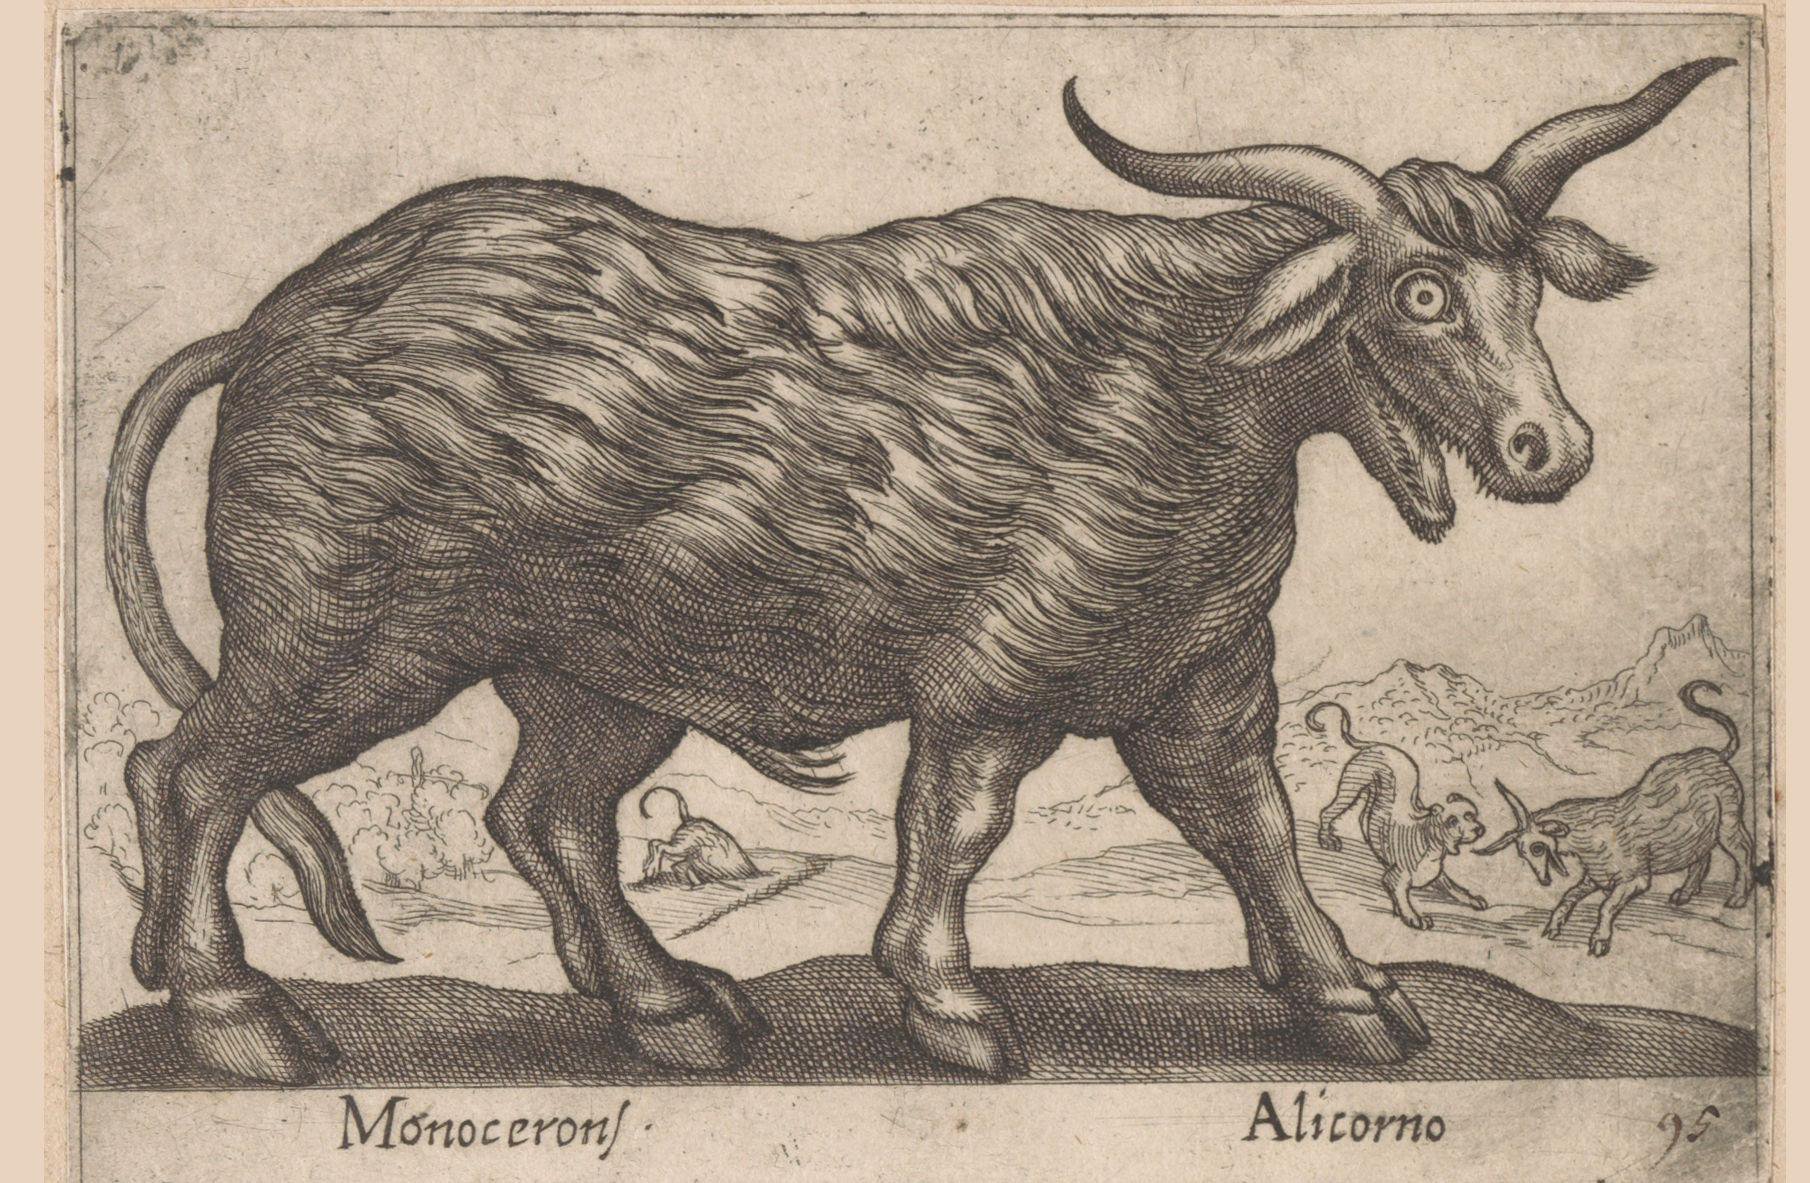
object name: print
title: Dieren en fabelwezens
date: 1565-1630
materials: paper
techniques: etching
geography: rome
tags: ox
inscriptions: number: ‘95’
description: Deze prent maakt deel uit van een reeks prenten van dieren door Antonio Tempesta. Bekend is dat een tweede staat (met nummering) van deze serie is uitgegeven door Giovanni Giacomo de' Rossi in 1650. Onbekend is wie de eerste staat heeft uitgegeven en wanneer.